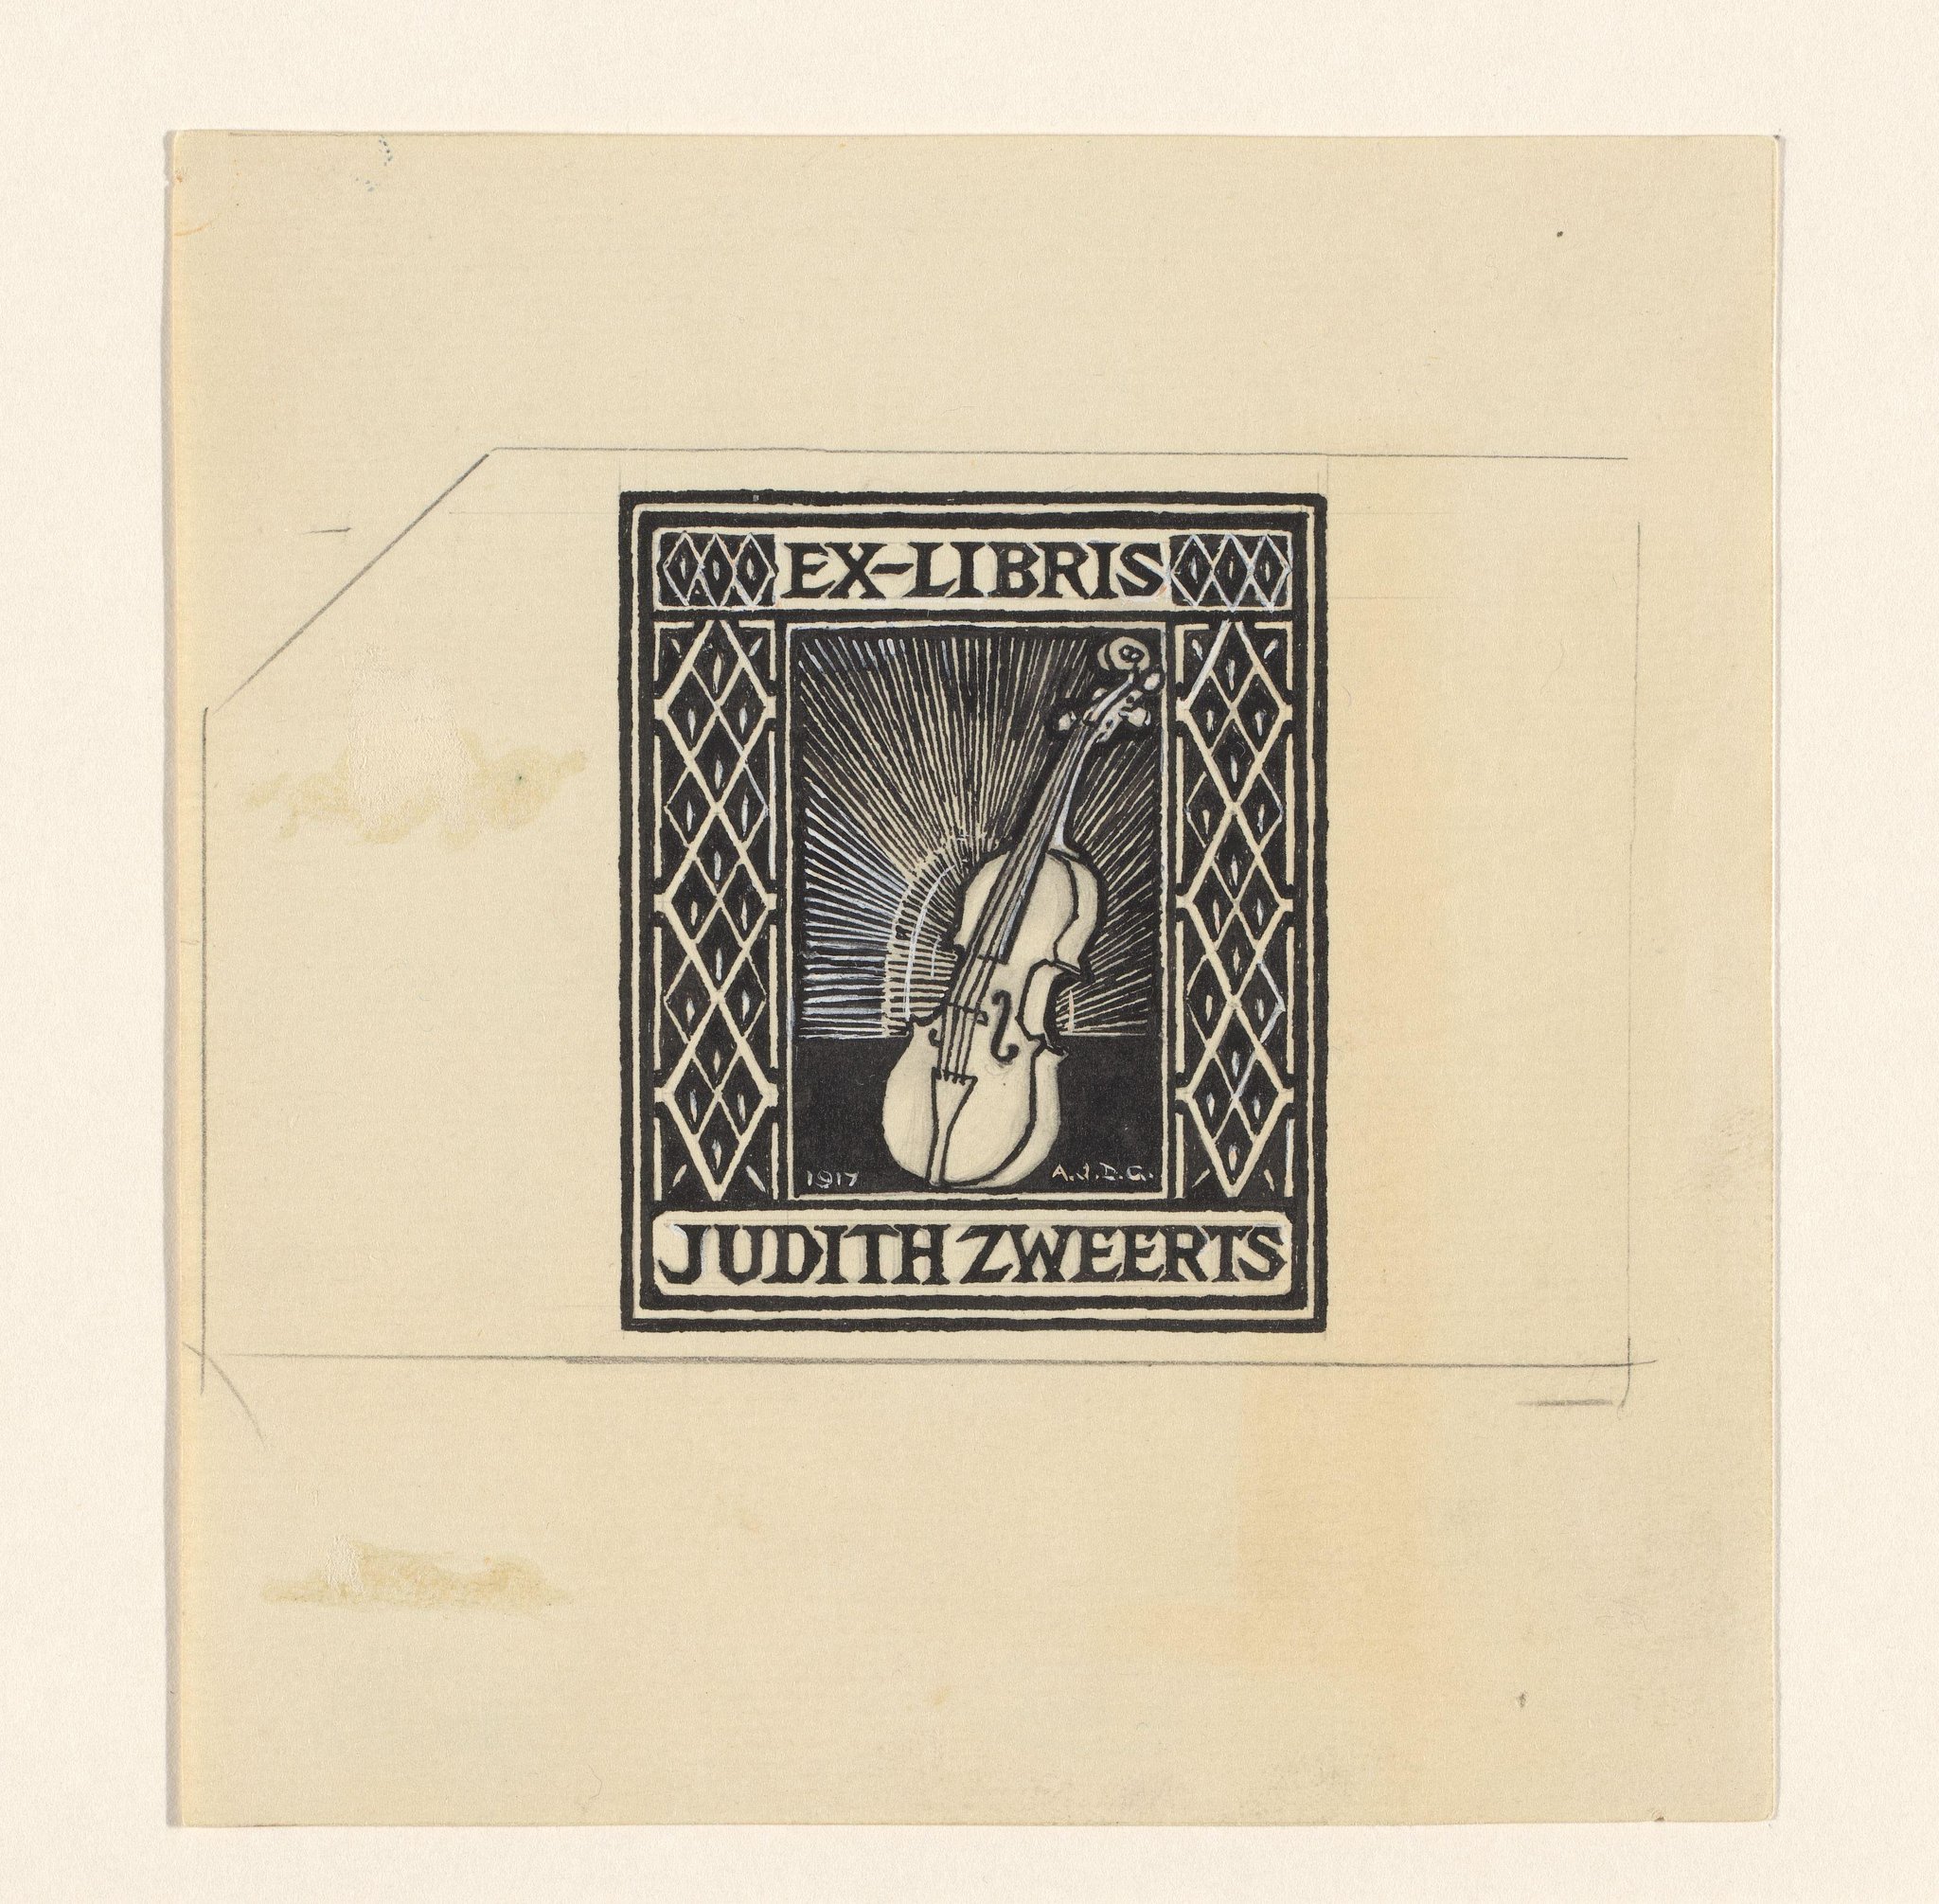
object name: drawing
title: Ontwerp voor een ex libris van Judith Zweerts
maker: julie de graag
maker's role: draughtsman, print maker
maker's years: 1877-1924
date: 1917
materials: paint, ink, paper, pencil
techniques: brush, pen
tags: violin, fiddle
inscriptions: number: ‘130D’